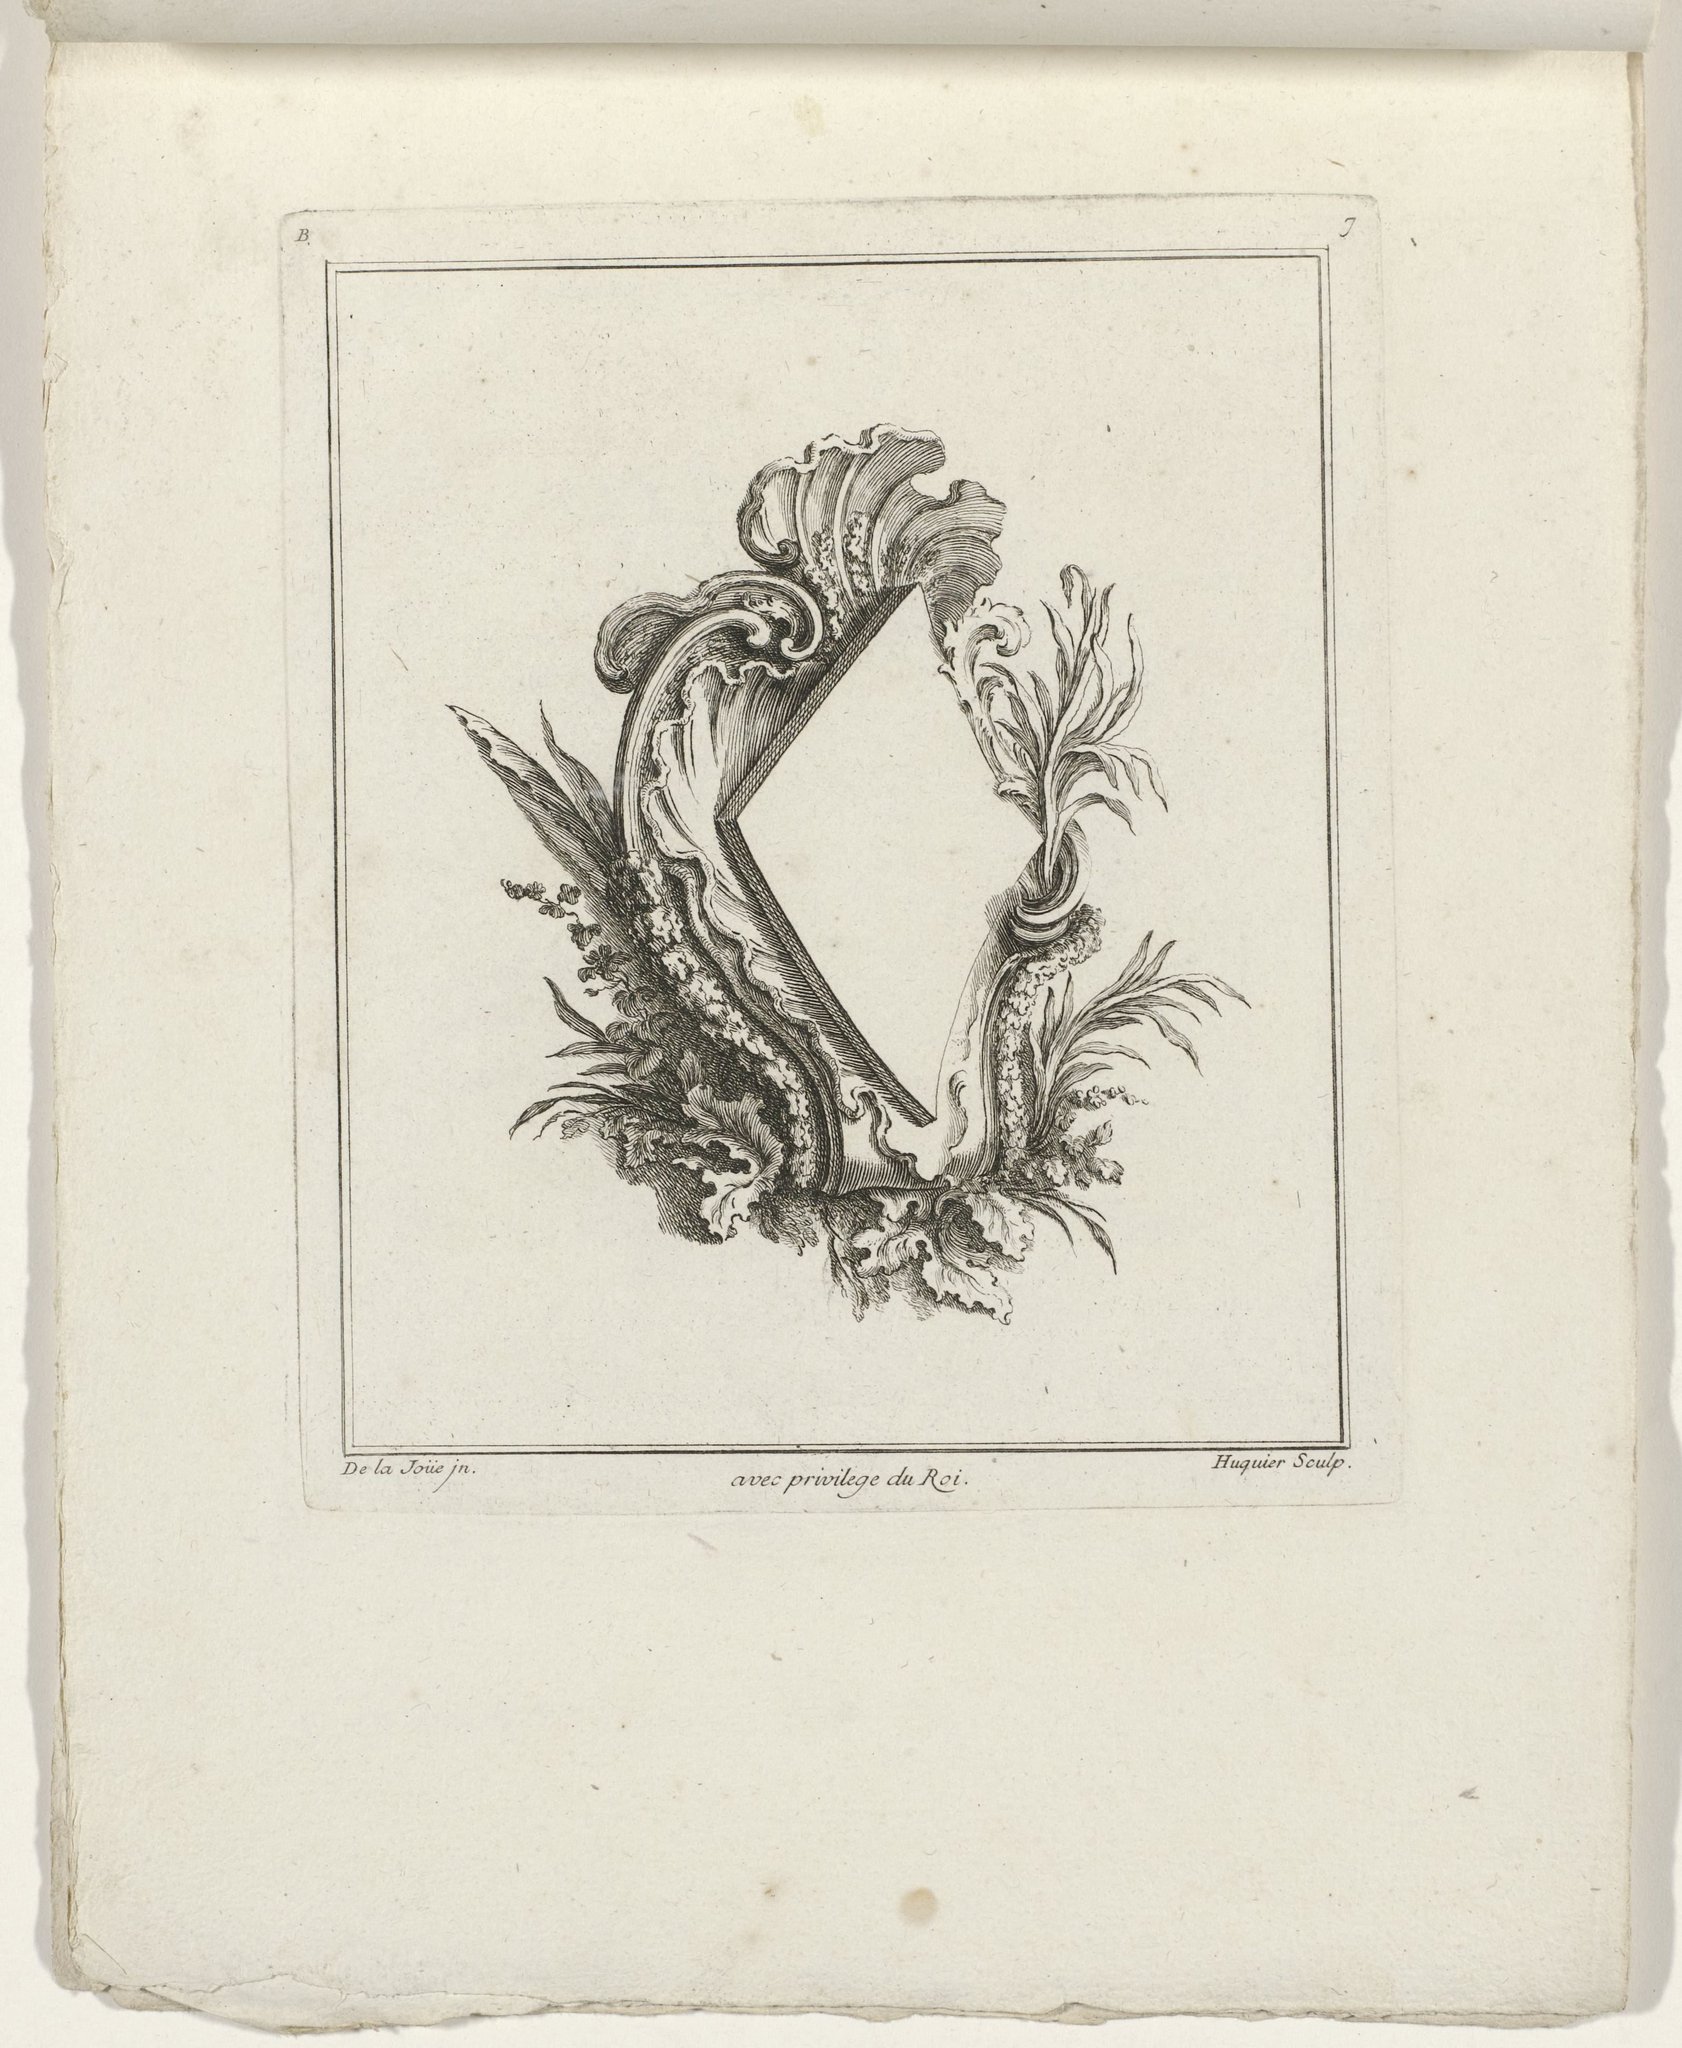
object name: ornament print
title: Second livre de cartouches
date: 1710-1772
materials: paper, fiber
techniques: engraving, etching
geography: paris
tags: ornament derived from plant forms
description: Ruitvormige cartouche omgeven door schelpmotief met daaromheen voluten en verschillende bladeren. Onderdeel van een reeks van twaalf genummerde ornamentprenten.